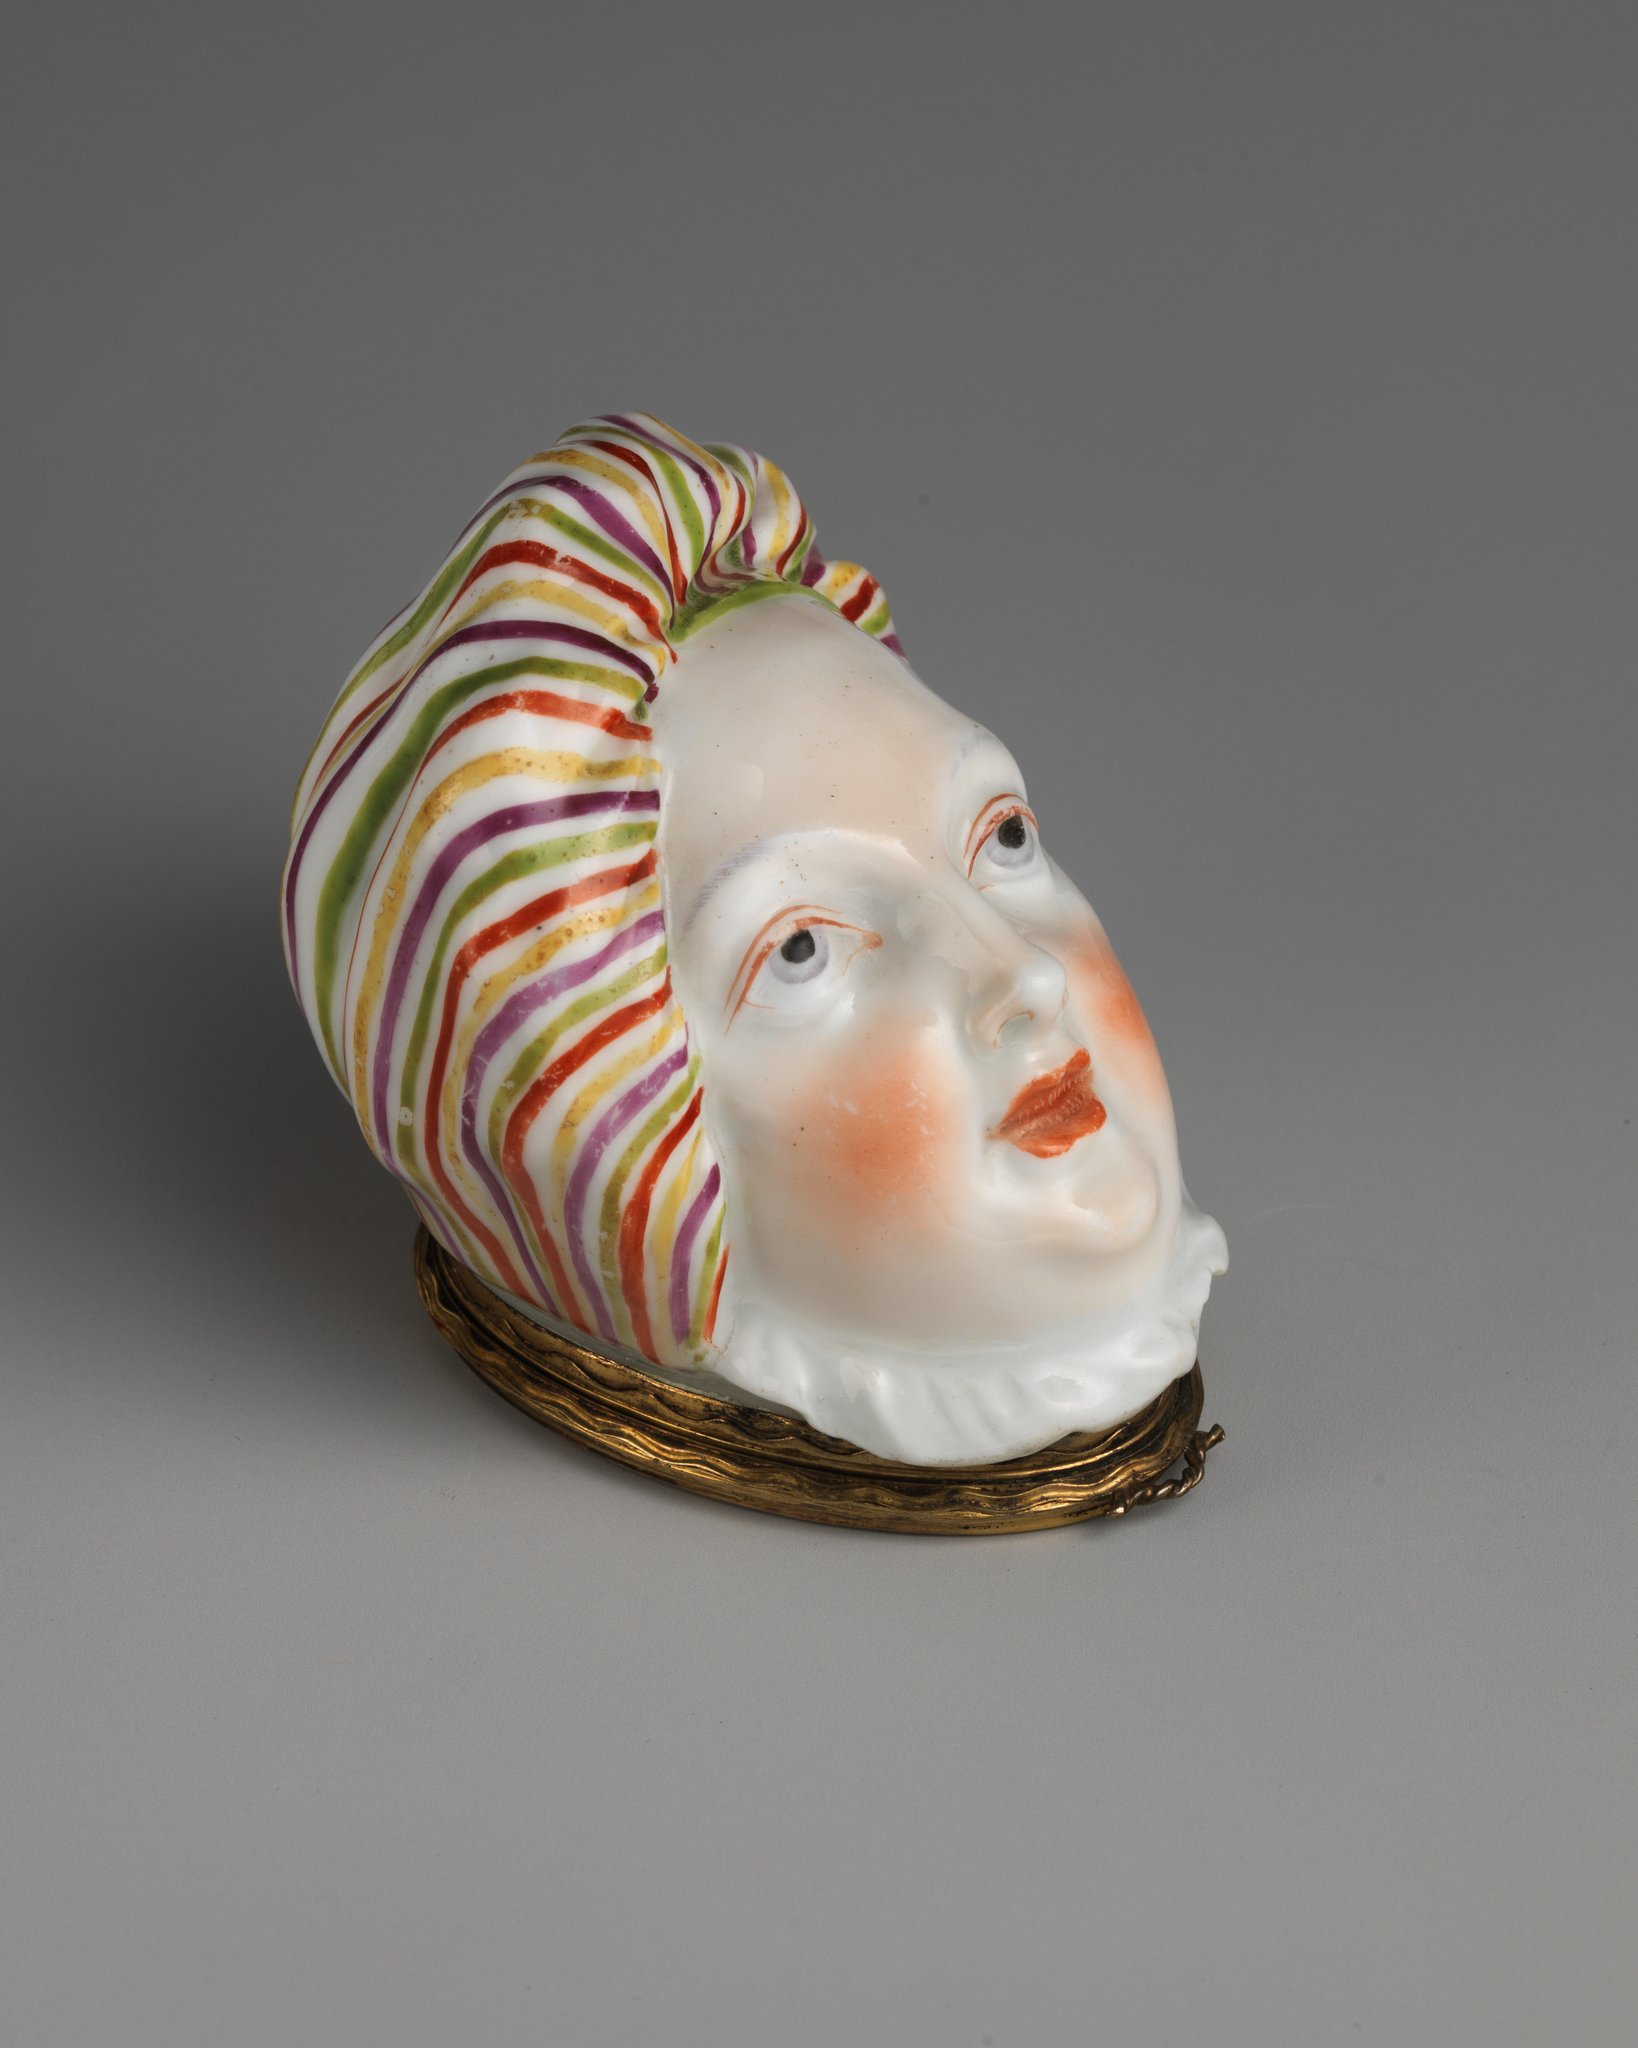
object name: toy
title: Man's head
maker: chelsea porcelain manufactory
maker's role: factory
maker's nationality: british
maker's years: 1744-1784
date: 1760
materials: soft paste porcelain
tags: heads,men